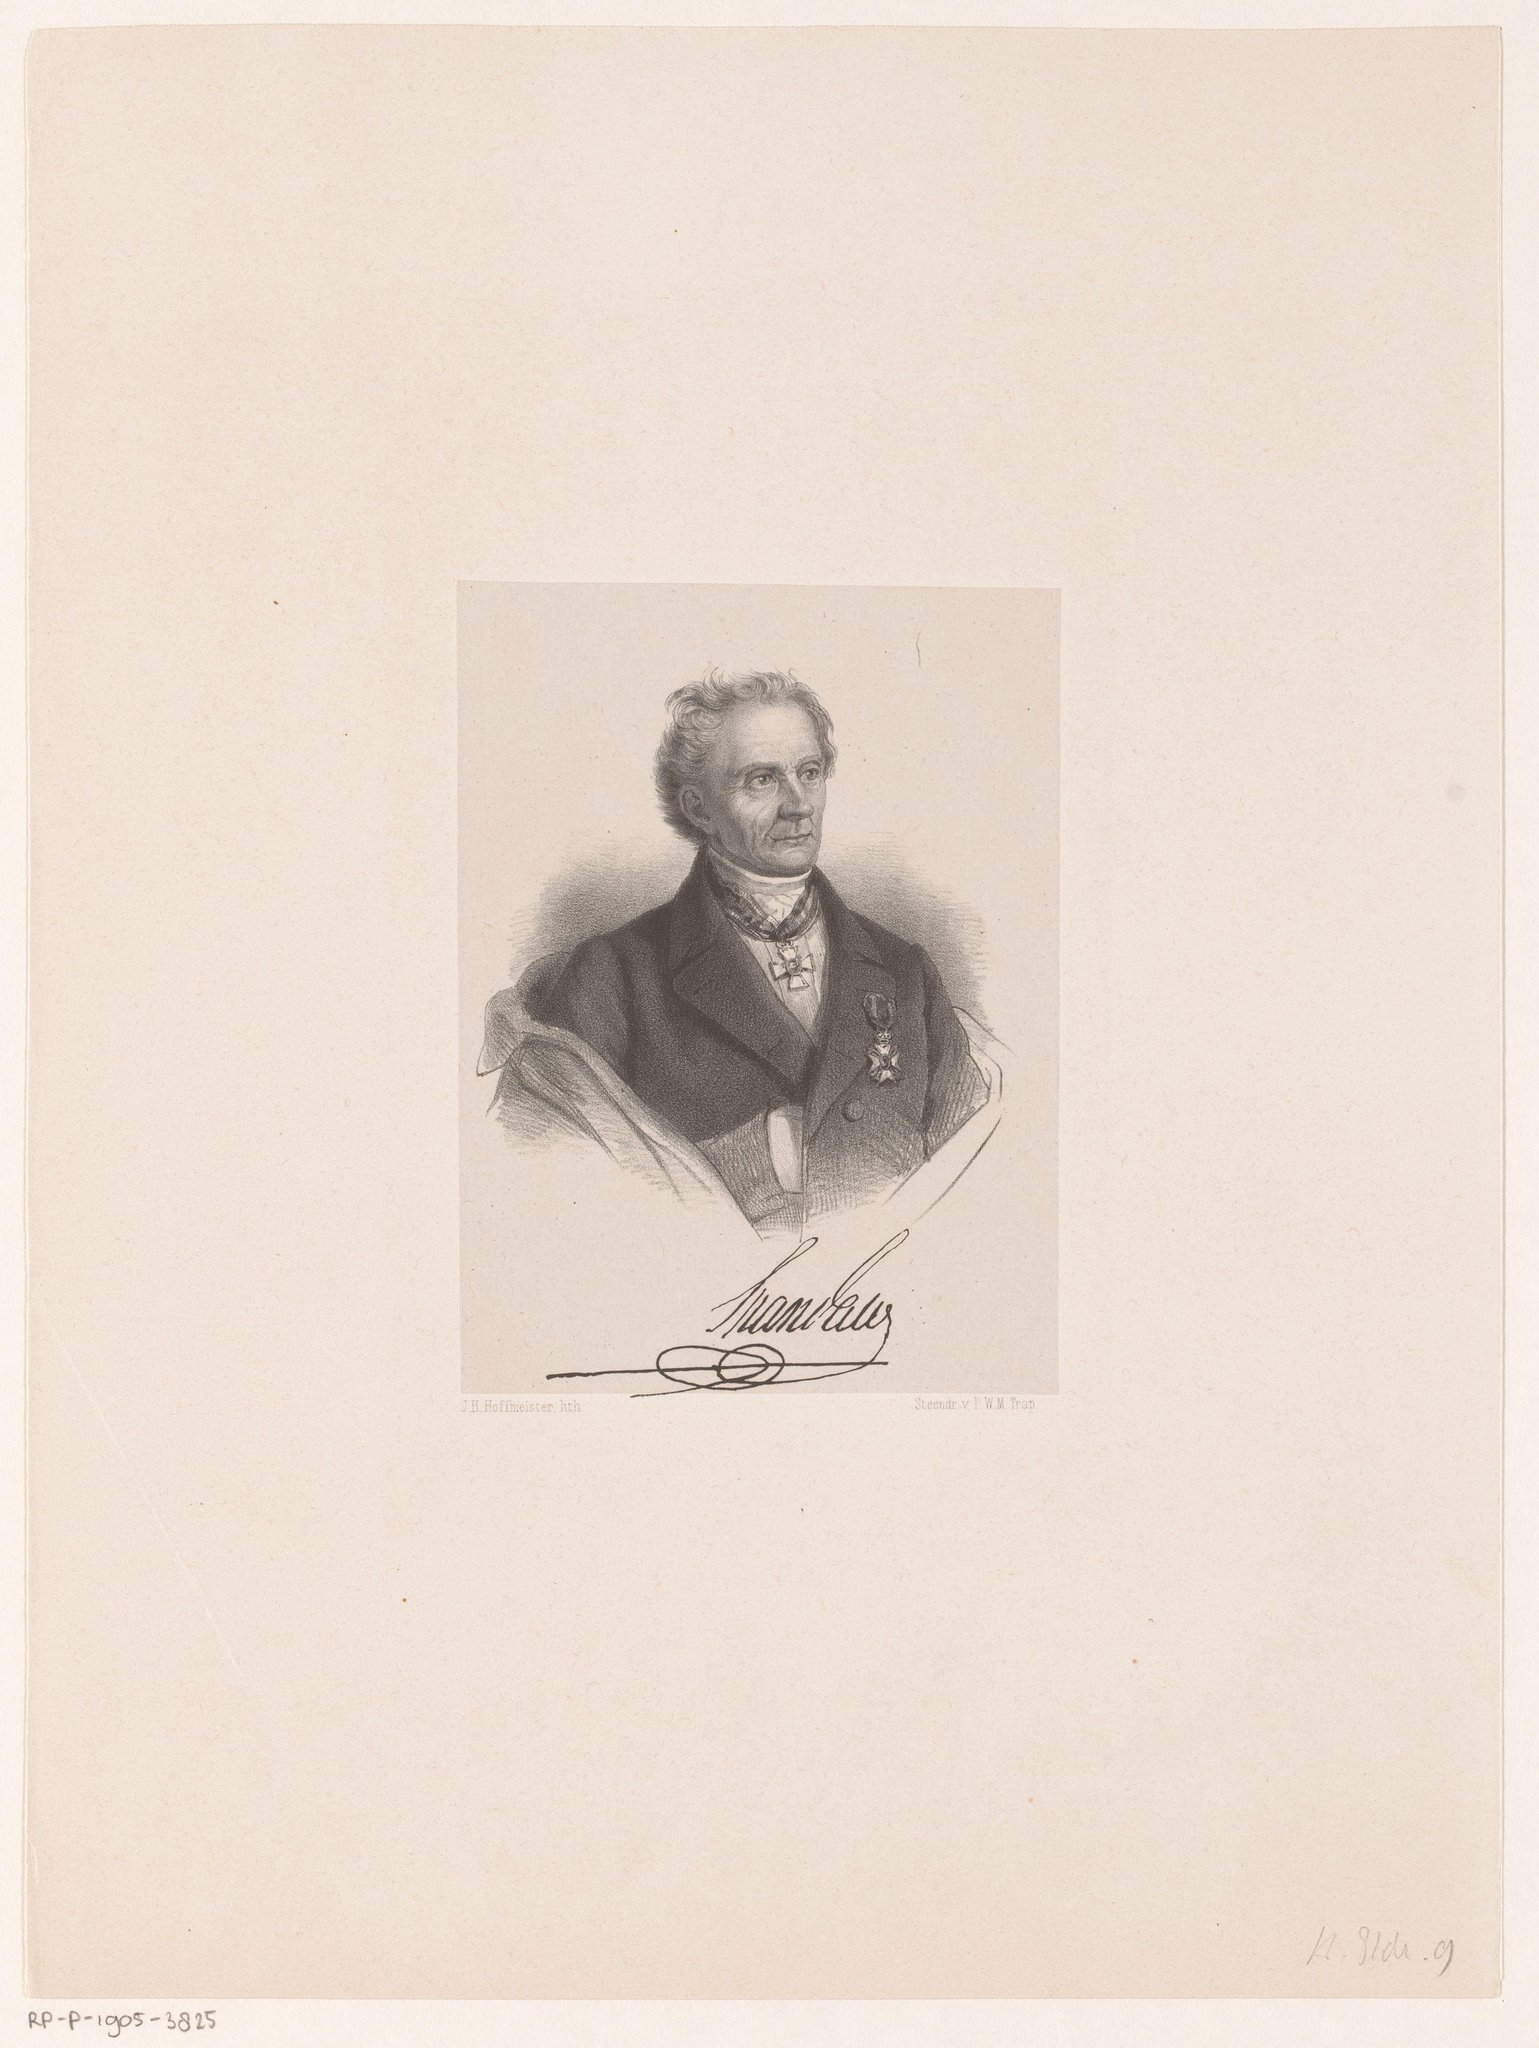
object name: print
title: Portret van Hajo Albert Spandaw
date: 1843-1891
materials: paper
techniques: lithograph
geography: leiden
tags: hajo albert spandaw, knighthood order, historical persons (+ (full) bust portrait)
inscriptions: collector's mark: Lugt 2228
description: De geportretteerde draagt twee ridderorden waaronder het grootkruis. Hij heeft zijn hand in zijn jas gestoken. Onder het portret zijn signatuur.